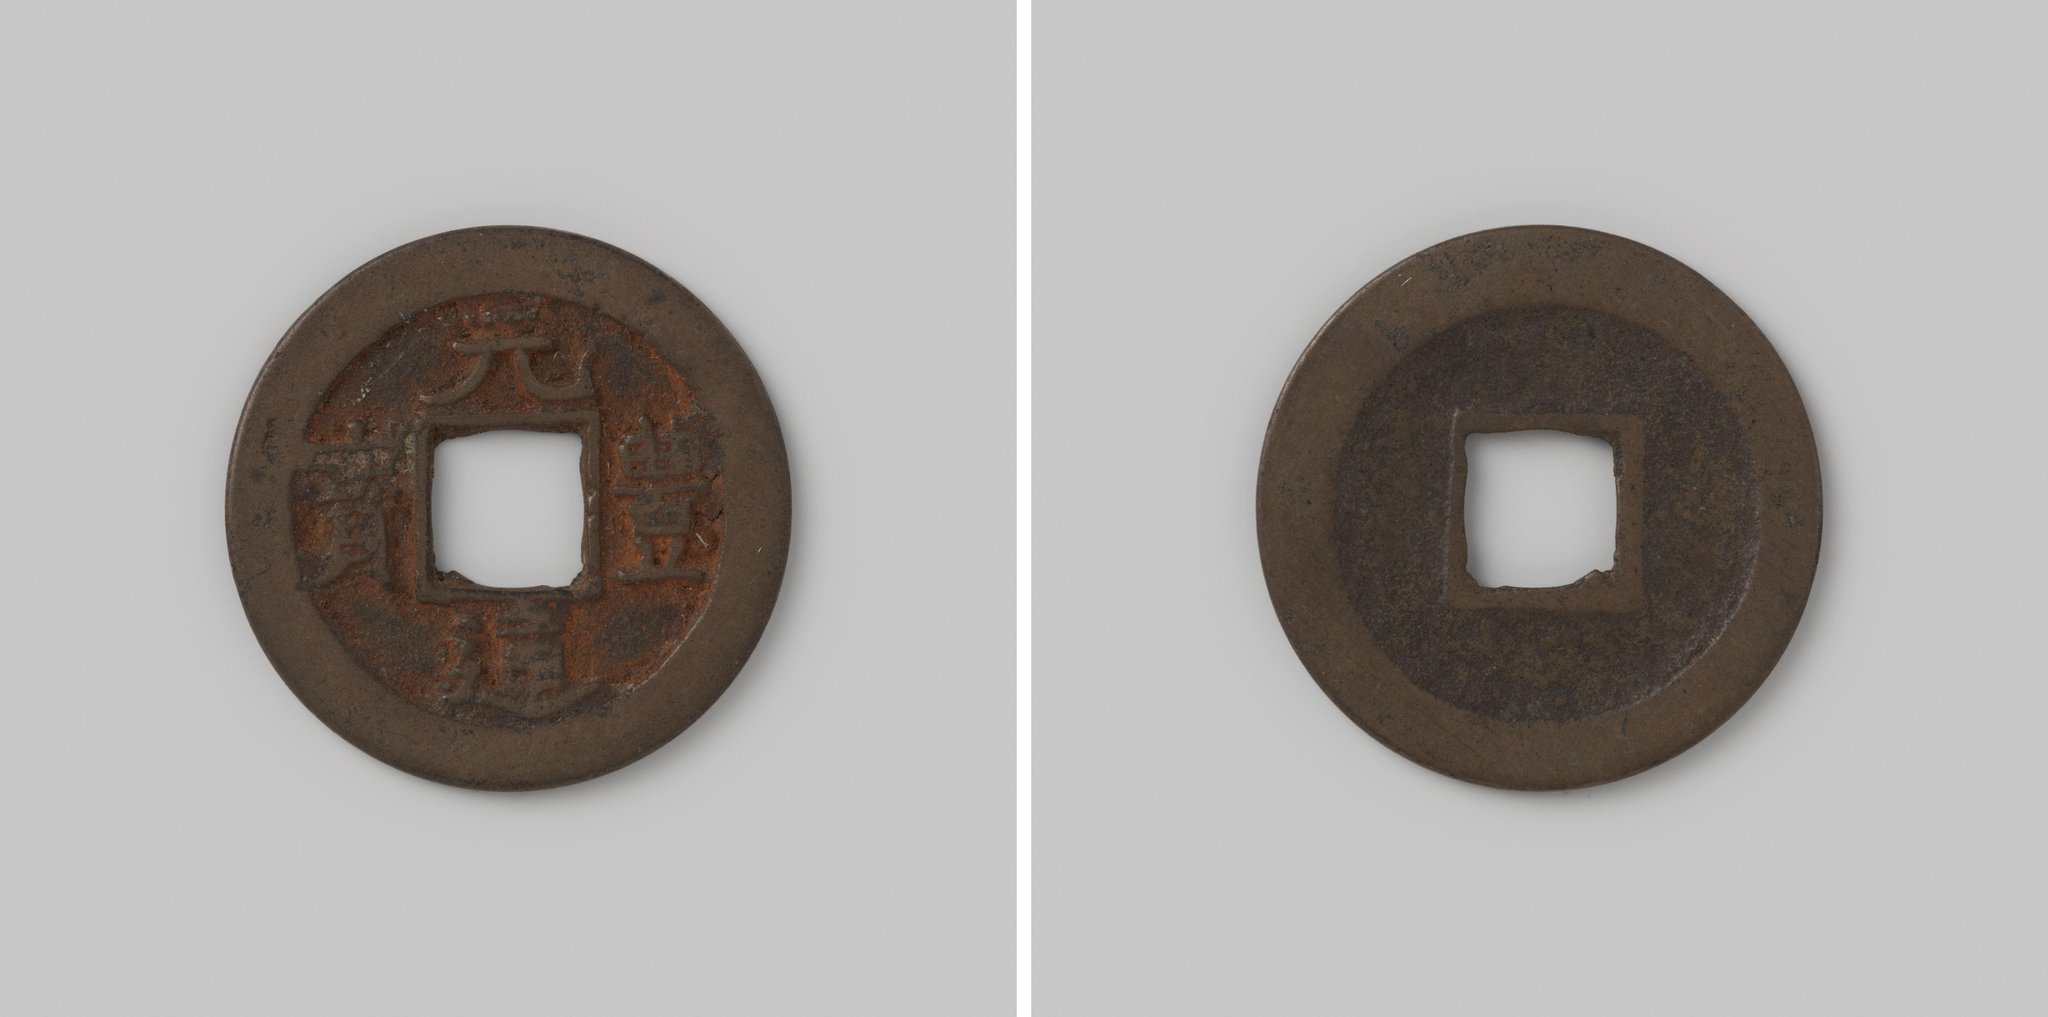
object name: coin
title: Cash van het keizerrijk China van keizer Shen Tsung onder de regeringsnaam Yuan-Feng,1078 -1085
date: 1078-1085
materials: copper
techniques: casting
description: Koperen munt. Voorzijde: binnen brede opstaande rand rondom vierkante uitsparing in het midden vier kruisgewijze geplaatste Chinese tekens, waarvan twee met de betekenis: Yuan feng. Keerzijde: glad binnen brede opstaande rand.